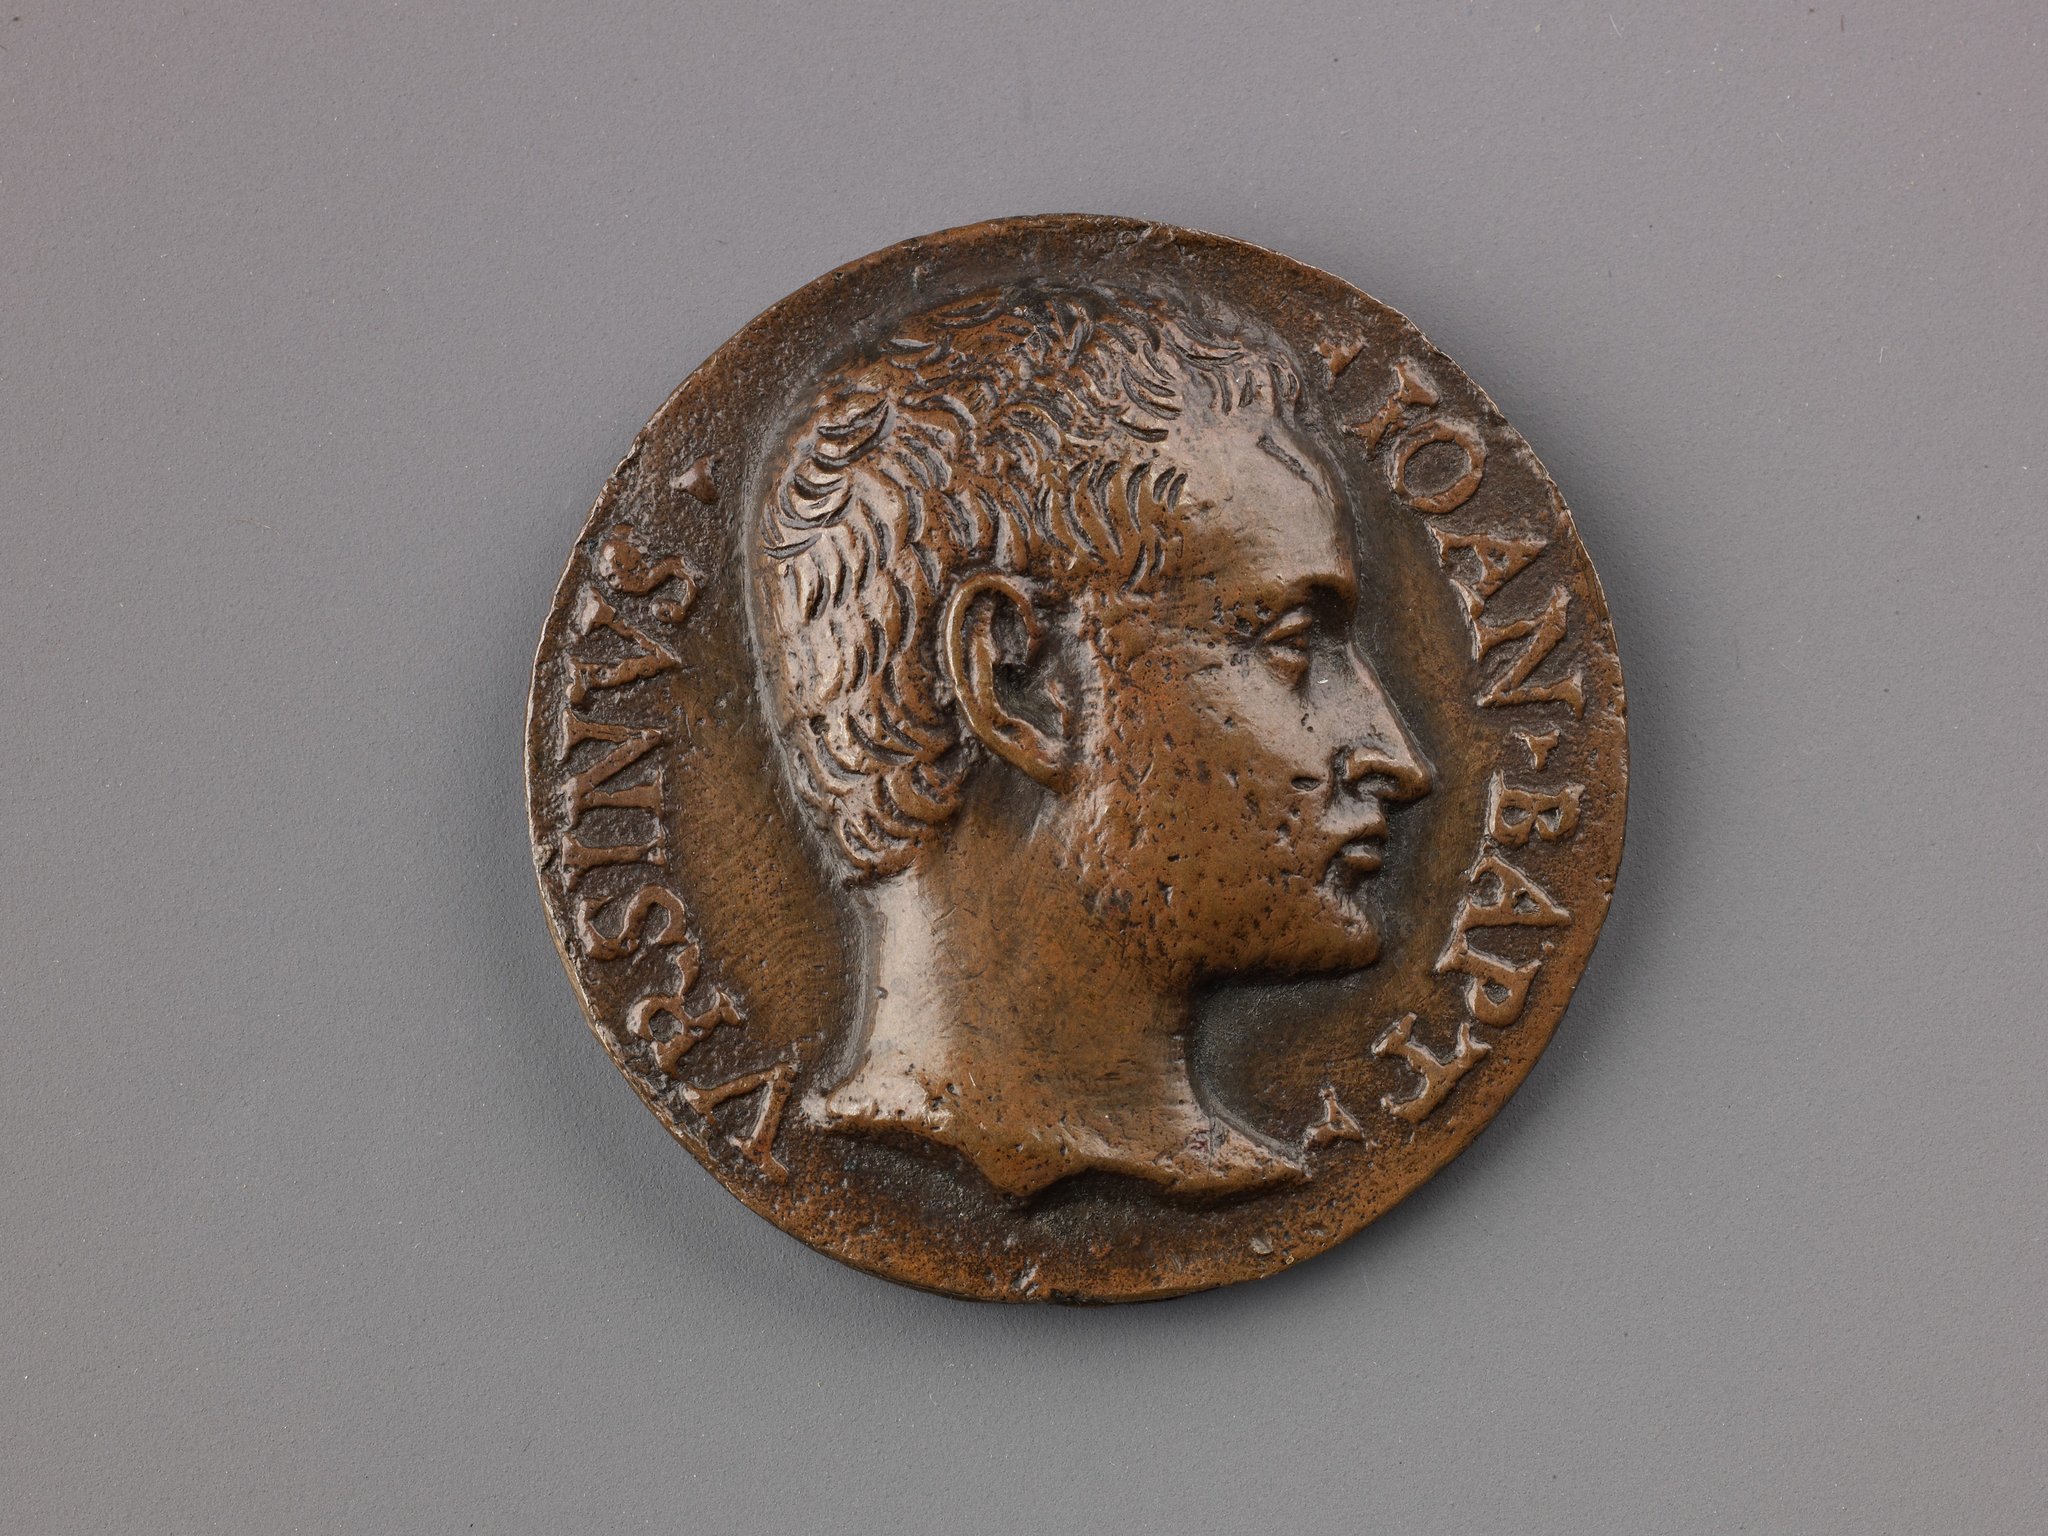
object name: medal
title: Medal: Bust of Gianbattista Orsini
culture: italian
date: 1467-1533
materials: bronze, copper alloy, patina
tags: men,portraits,profiles,unicorns